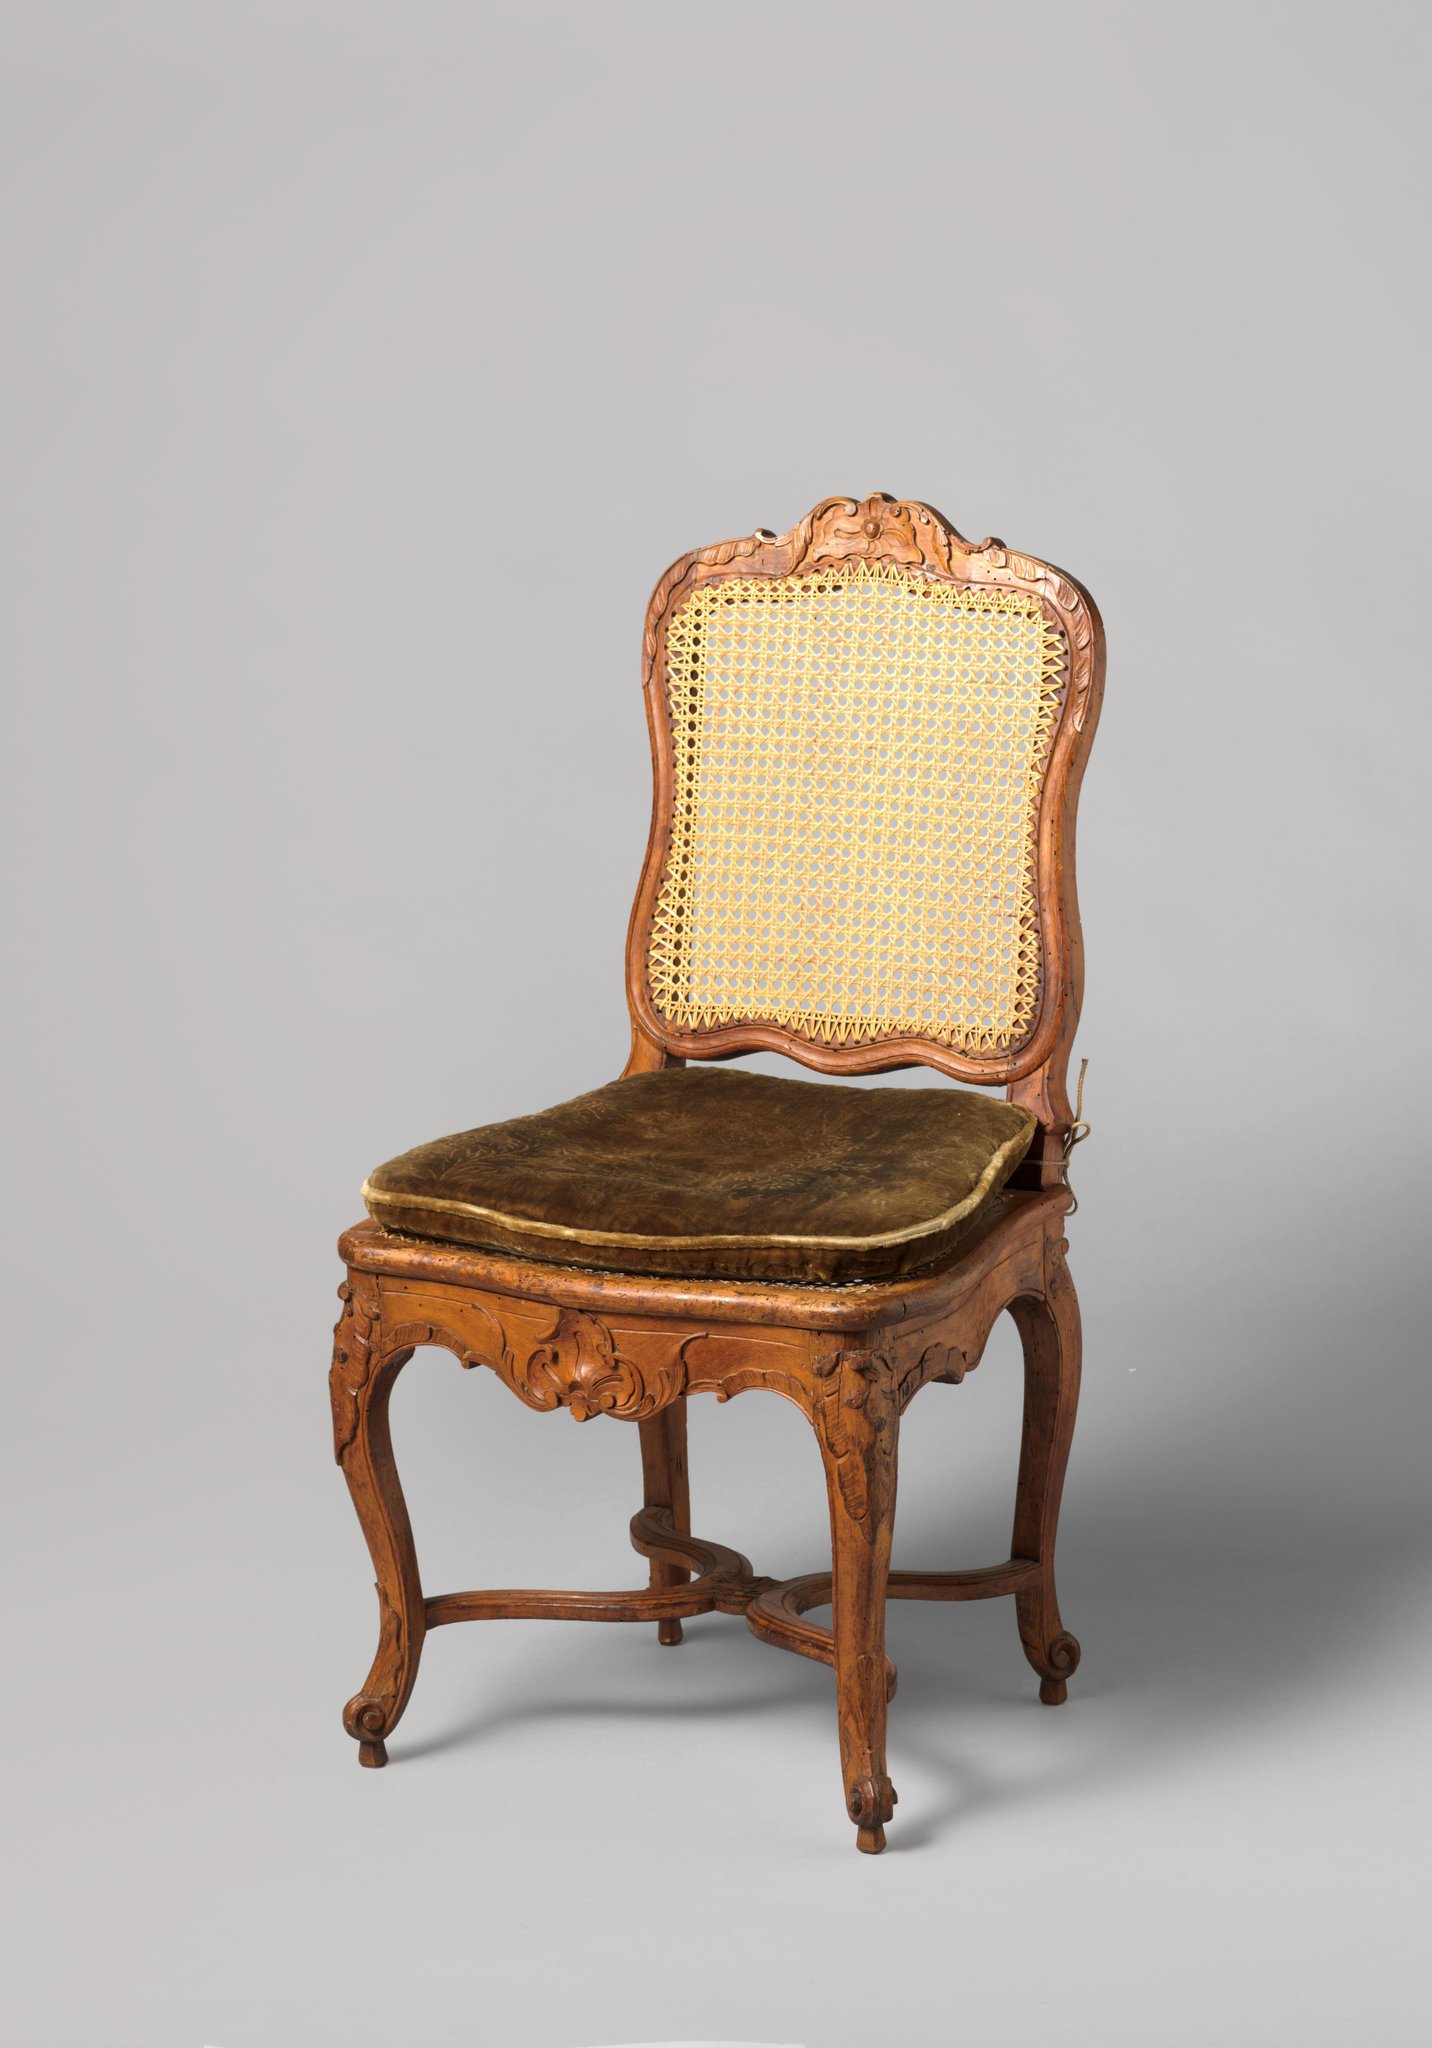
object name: suite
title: Stoel van noten- en beukenhout met S-vormige overhoeks geplaatste poten; X-vormig kruis met rozet; gesneden bloem- en bladwerk, rug en zitting van riet, met los kussen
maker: Anonymous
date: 1750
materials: wood, textile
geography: france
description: Stoel van note- en beukehout (ameublement) met S-vormige overhoeks geplaatste poten, verbonden door een geslingerd X-vormig kruis met rozet. Regels en dorpels en poten zijn versierd met gesneden bloem- en bladmotieven. Rug en zitting van gevlochten riet. Los kussen van groen geschoren trijp (modern). Zie ook: BK-16852-E t/m P.